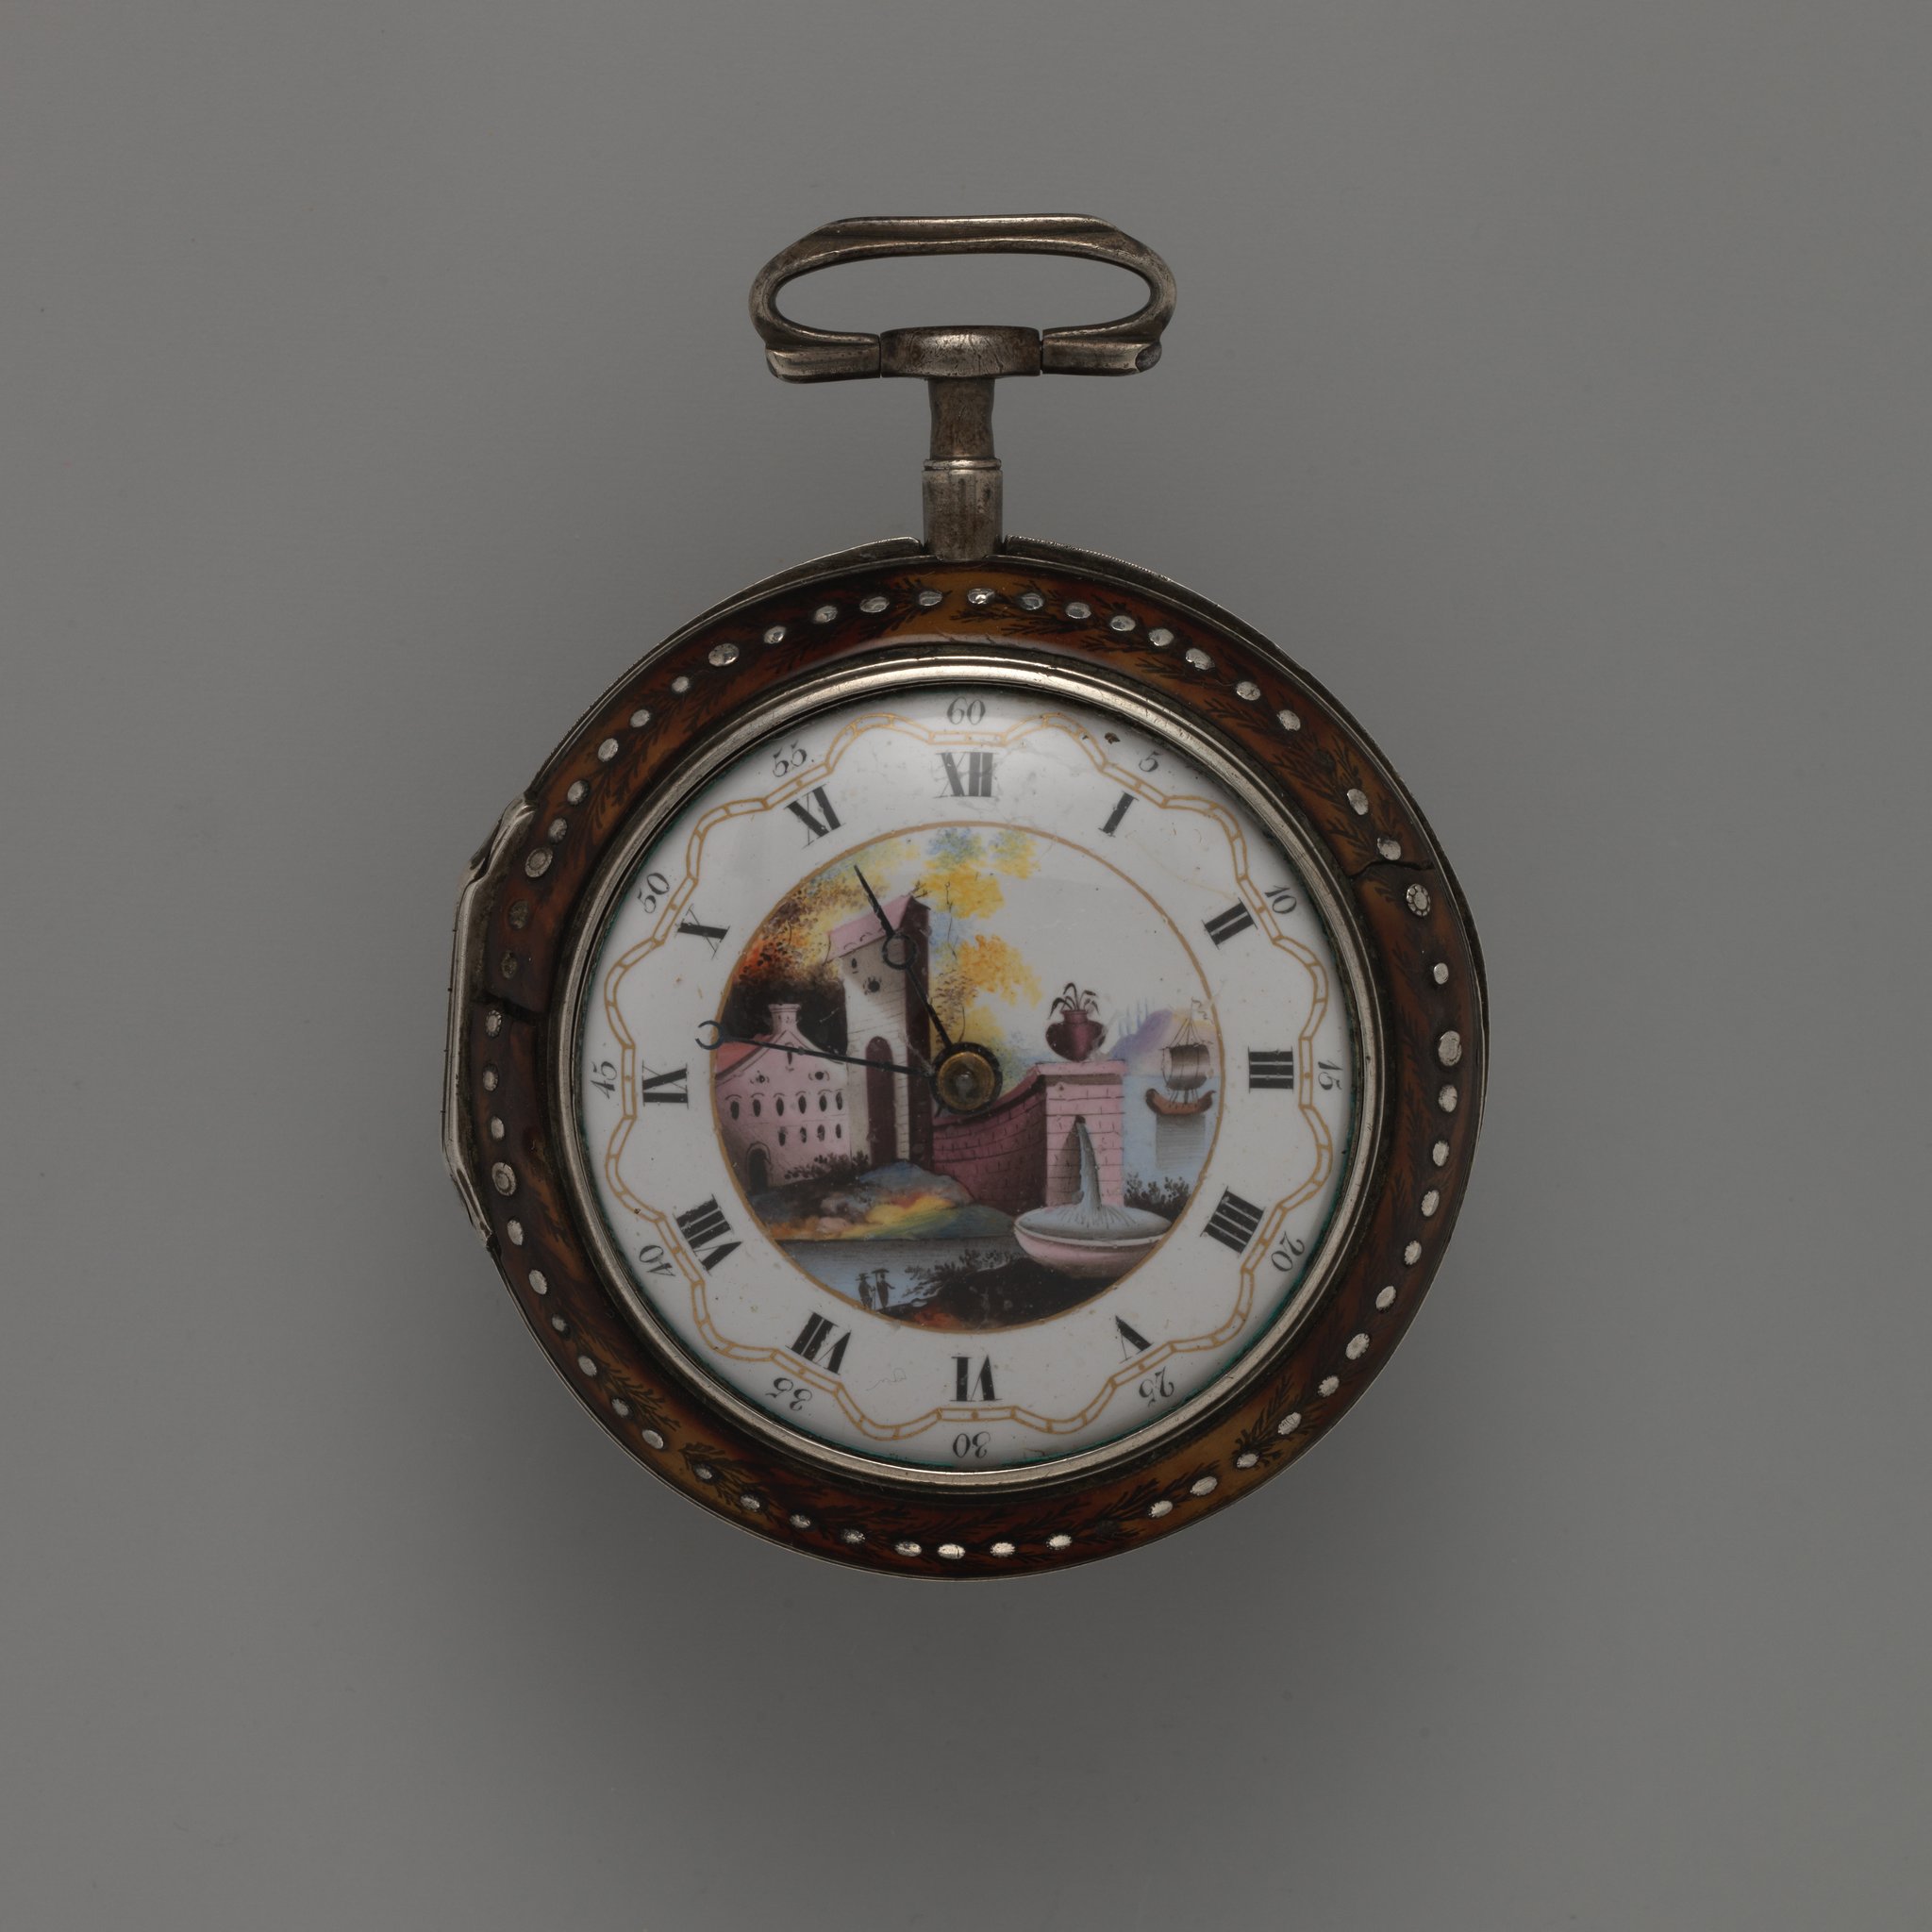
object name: watch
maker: j. samson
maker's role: maker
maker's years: 1760-1796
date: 1701-1800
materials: enamel, gold, silver, shell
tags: buildings,ships